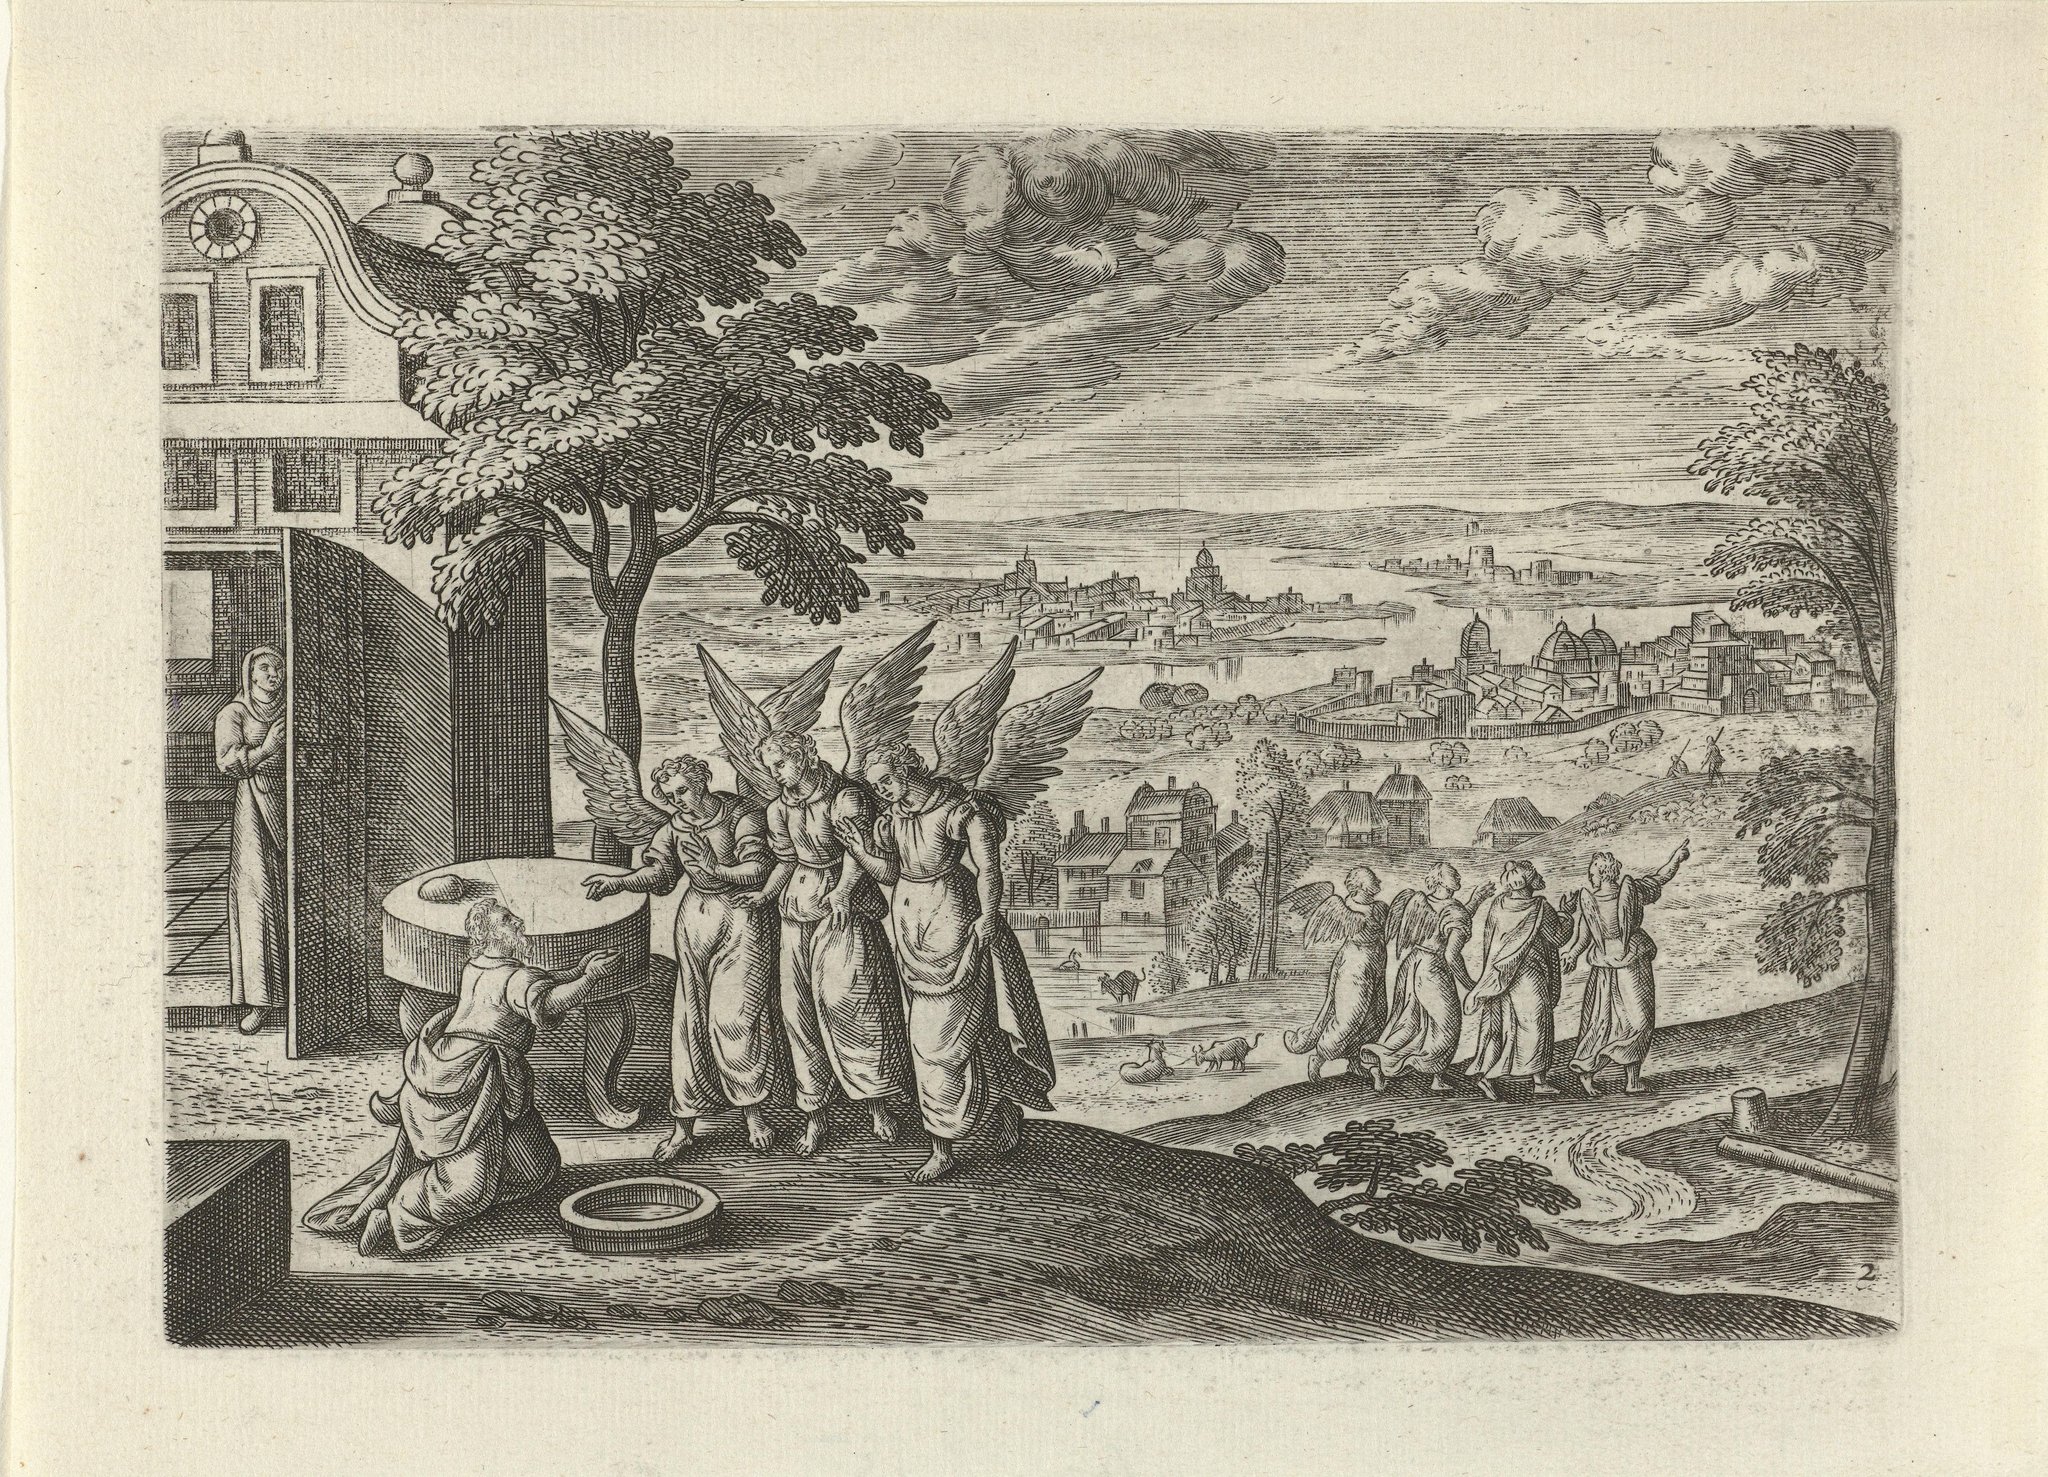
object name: print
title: Landschappen met scènes uit het Oude en Nieuwe Testament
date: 1560-1595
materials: paper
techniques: engraving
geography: antwerp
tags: abraham kneels before the angels, outskirts of city, abraham accompanying the departing angels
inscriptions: collector's mark: Lugt 2228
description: Abraham knielt voor de drie engelen en verwelkomt hen in zijn huis. Sara staat in de deur van de woning. Op de achtergrond leidt Abraham de engelen naar Sodom. De stad Sodom in de verte. De prent is deel van een vierdelige serie van landschappen met scènes uit het Oude en Nieuwe Testament.